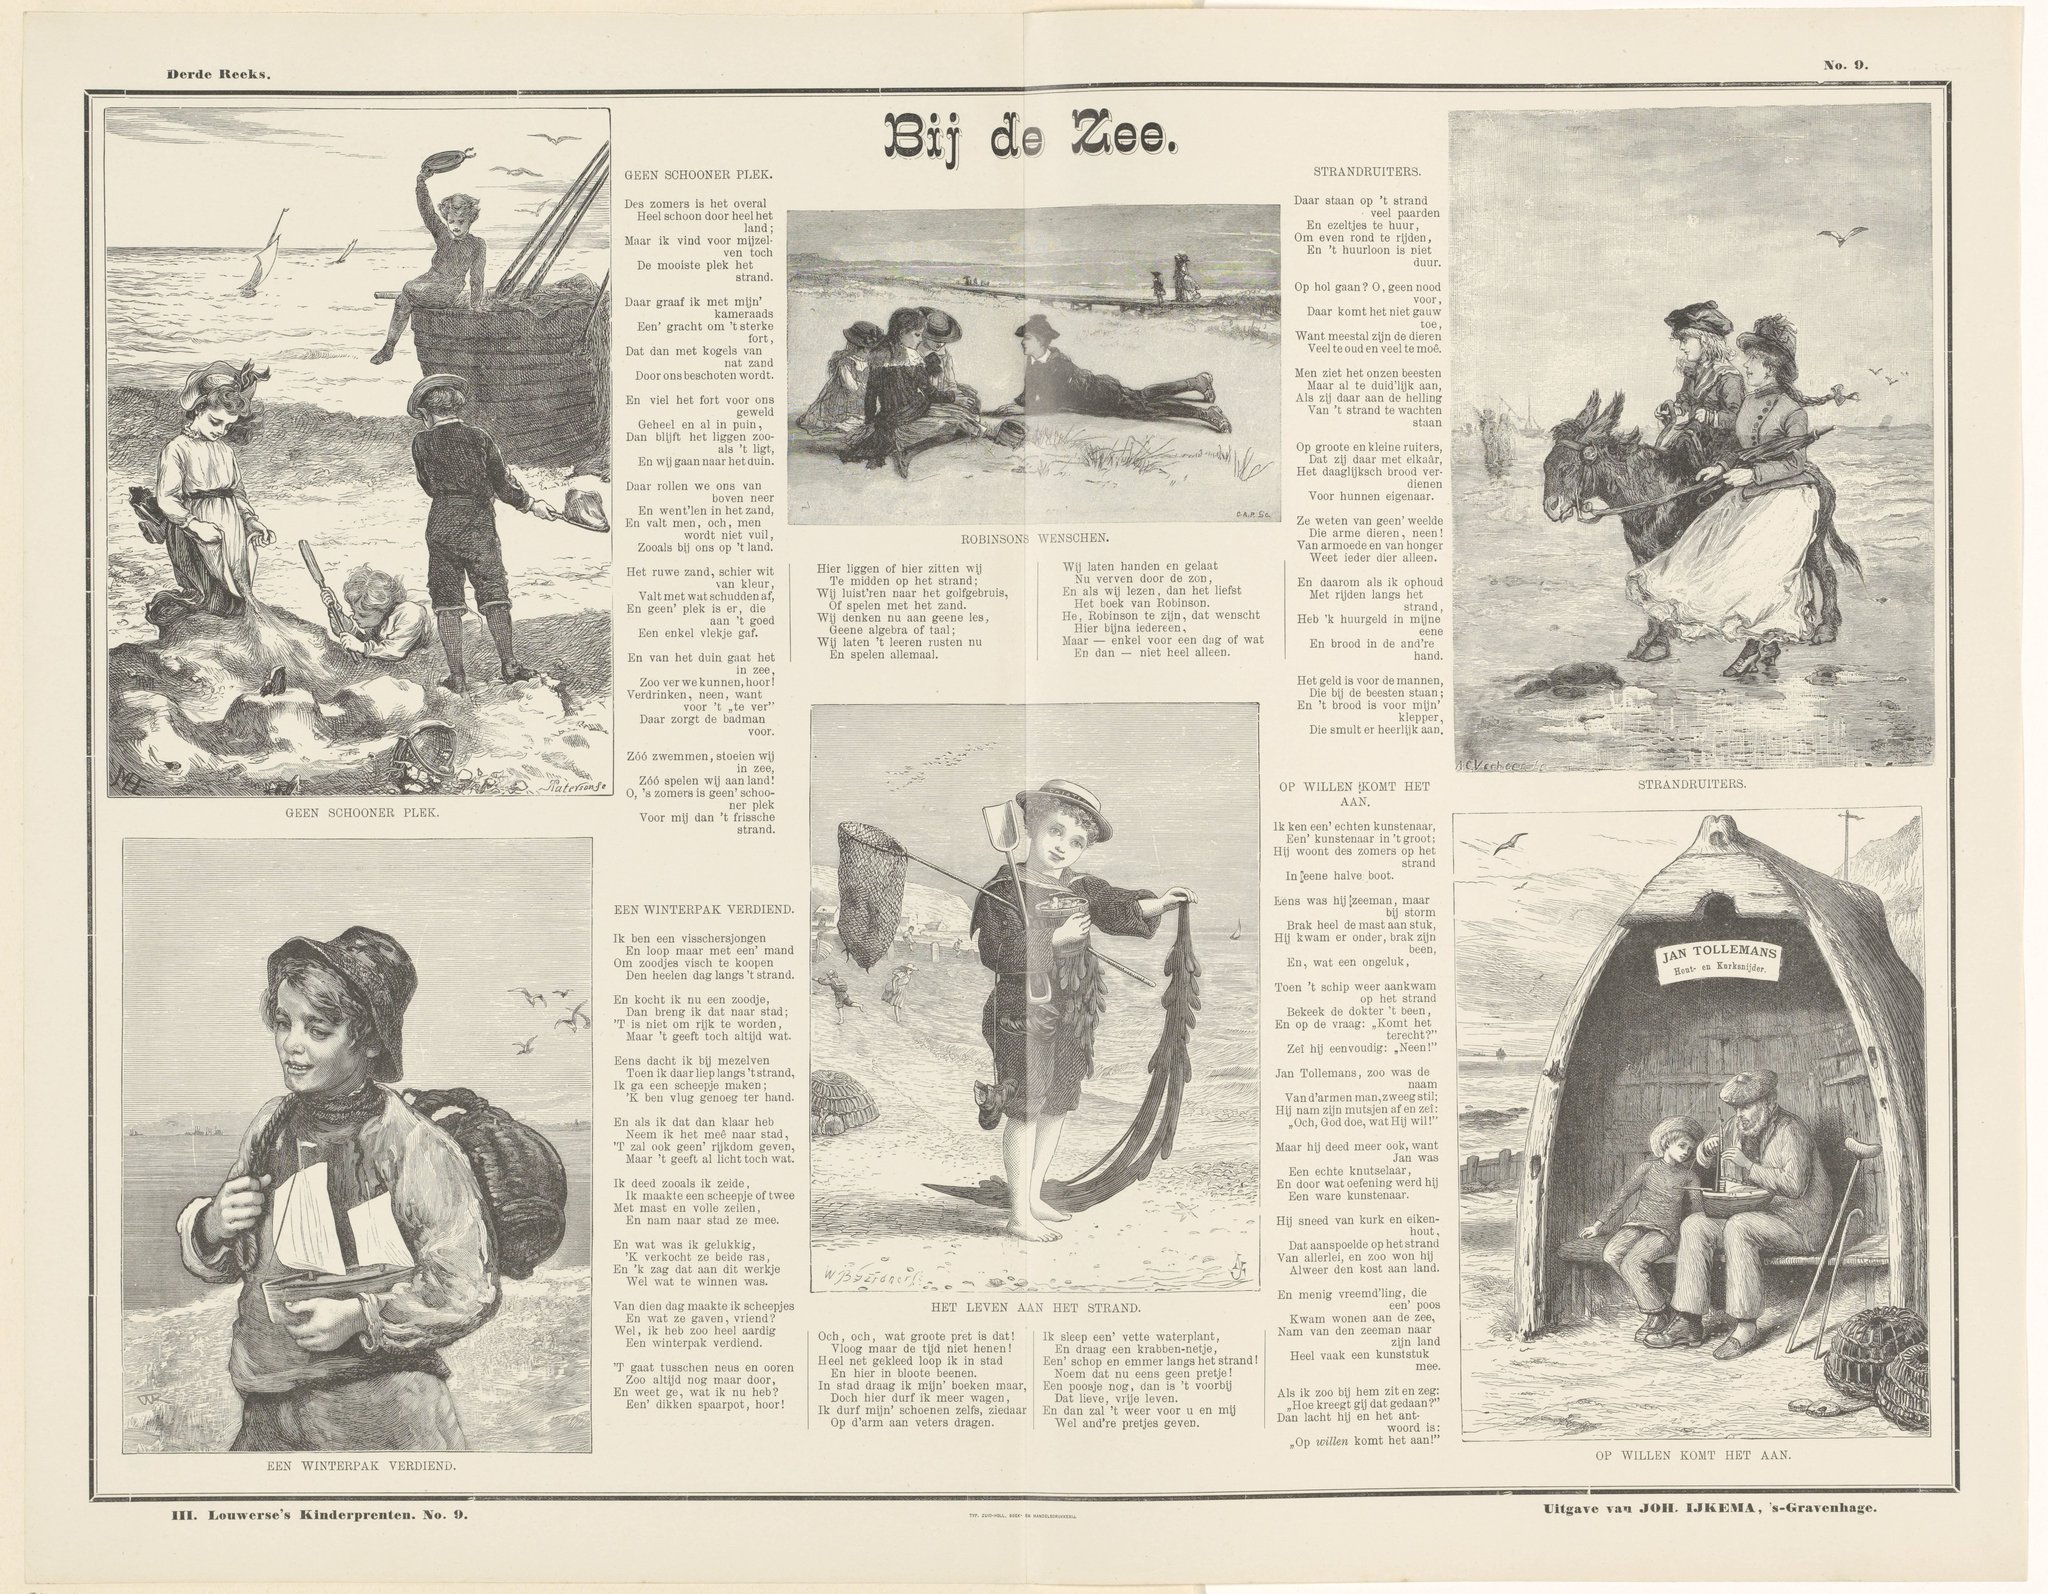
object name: popular print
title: Derde reeks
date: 1892-1905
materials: paper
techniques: letterpress printing, printing block, engraving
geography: the hague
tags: beach (as place of recreation), beach, donkey-riding (on the beach), in or beside the water (on the beach)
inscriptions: collector's mark: Lugt 2760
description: Blad met 6 voorstellingen van spelende kinderen op het strand. Tussen de afbeeldingen versjes in boekdruk. Genummerd rechtsboven en linksonder: No. 9.